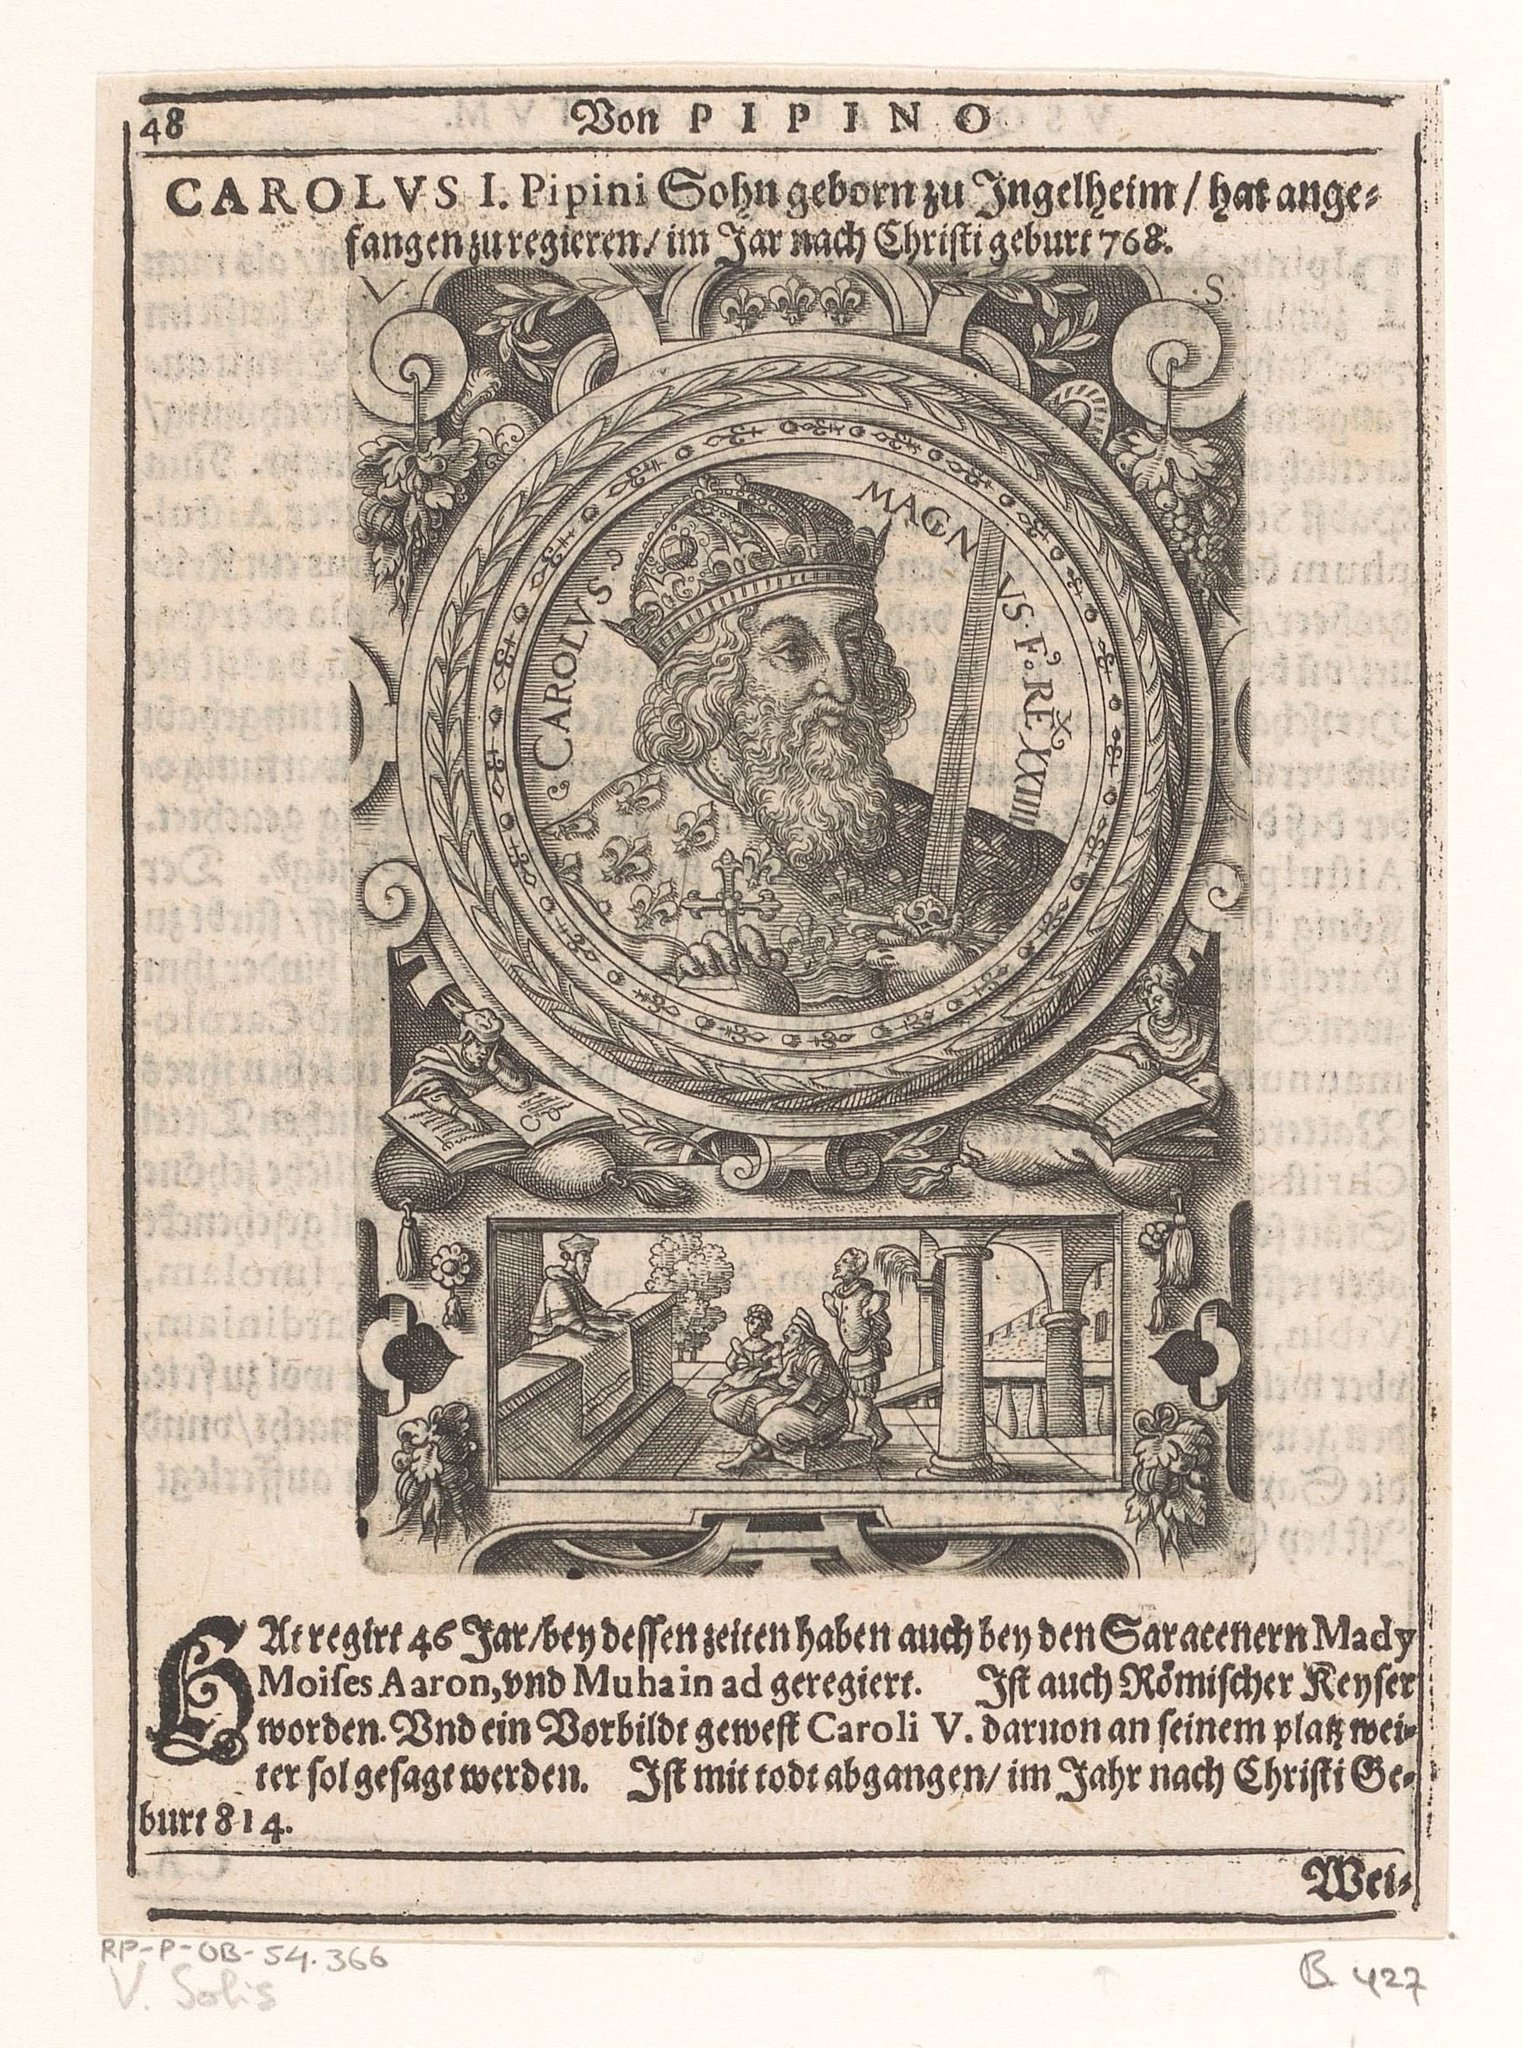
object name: book illustration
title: Portret van Karel de Grote, keizer van het Heilige Roomse Rijk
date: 1598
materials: paper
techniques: engraving, etching, intaglio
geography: nuremberg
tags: charlemagne (holy roman emperor), scrollwork, strapwork ~ ornament, historical persons, ruler, sovereign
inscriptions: collector's mark: Lugt 2228, number: ‘158’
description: Prent afkomstig uit de publicatie: Michael Eizinger. Könige in Frankreich. Keulen: Johann Bussemacher, 1598, p. 48. De publicatie bevat prenten van Jost Amman en Virgil Solis.